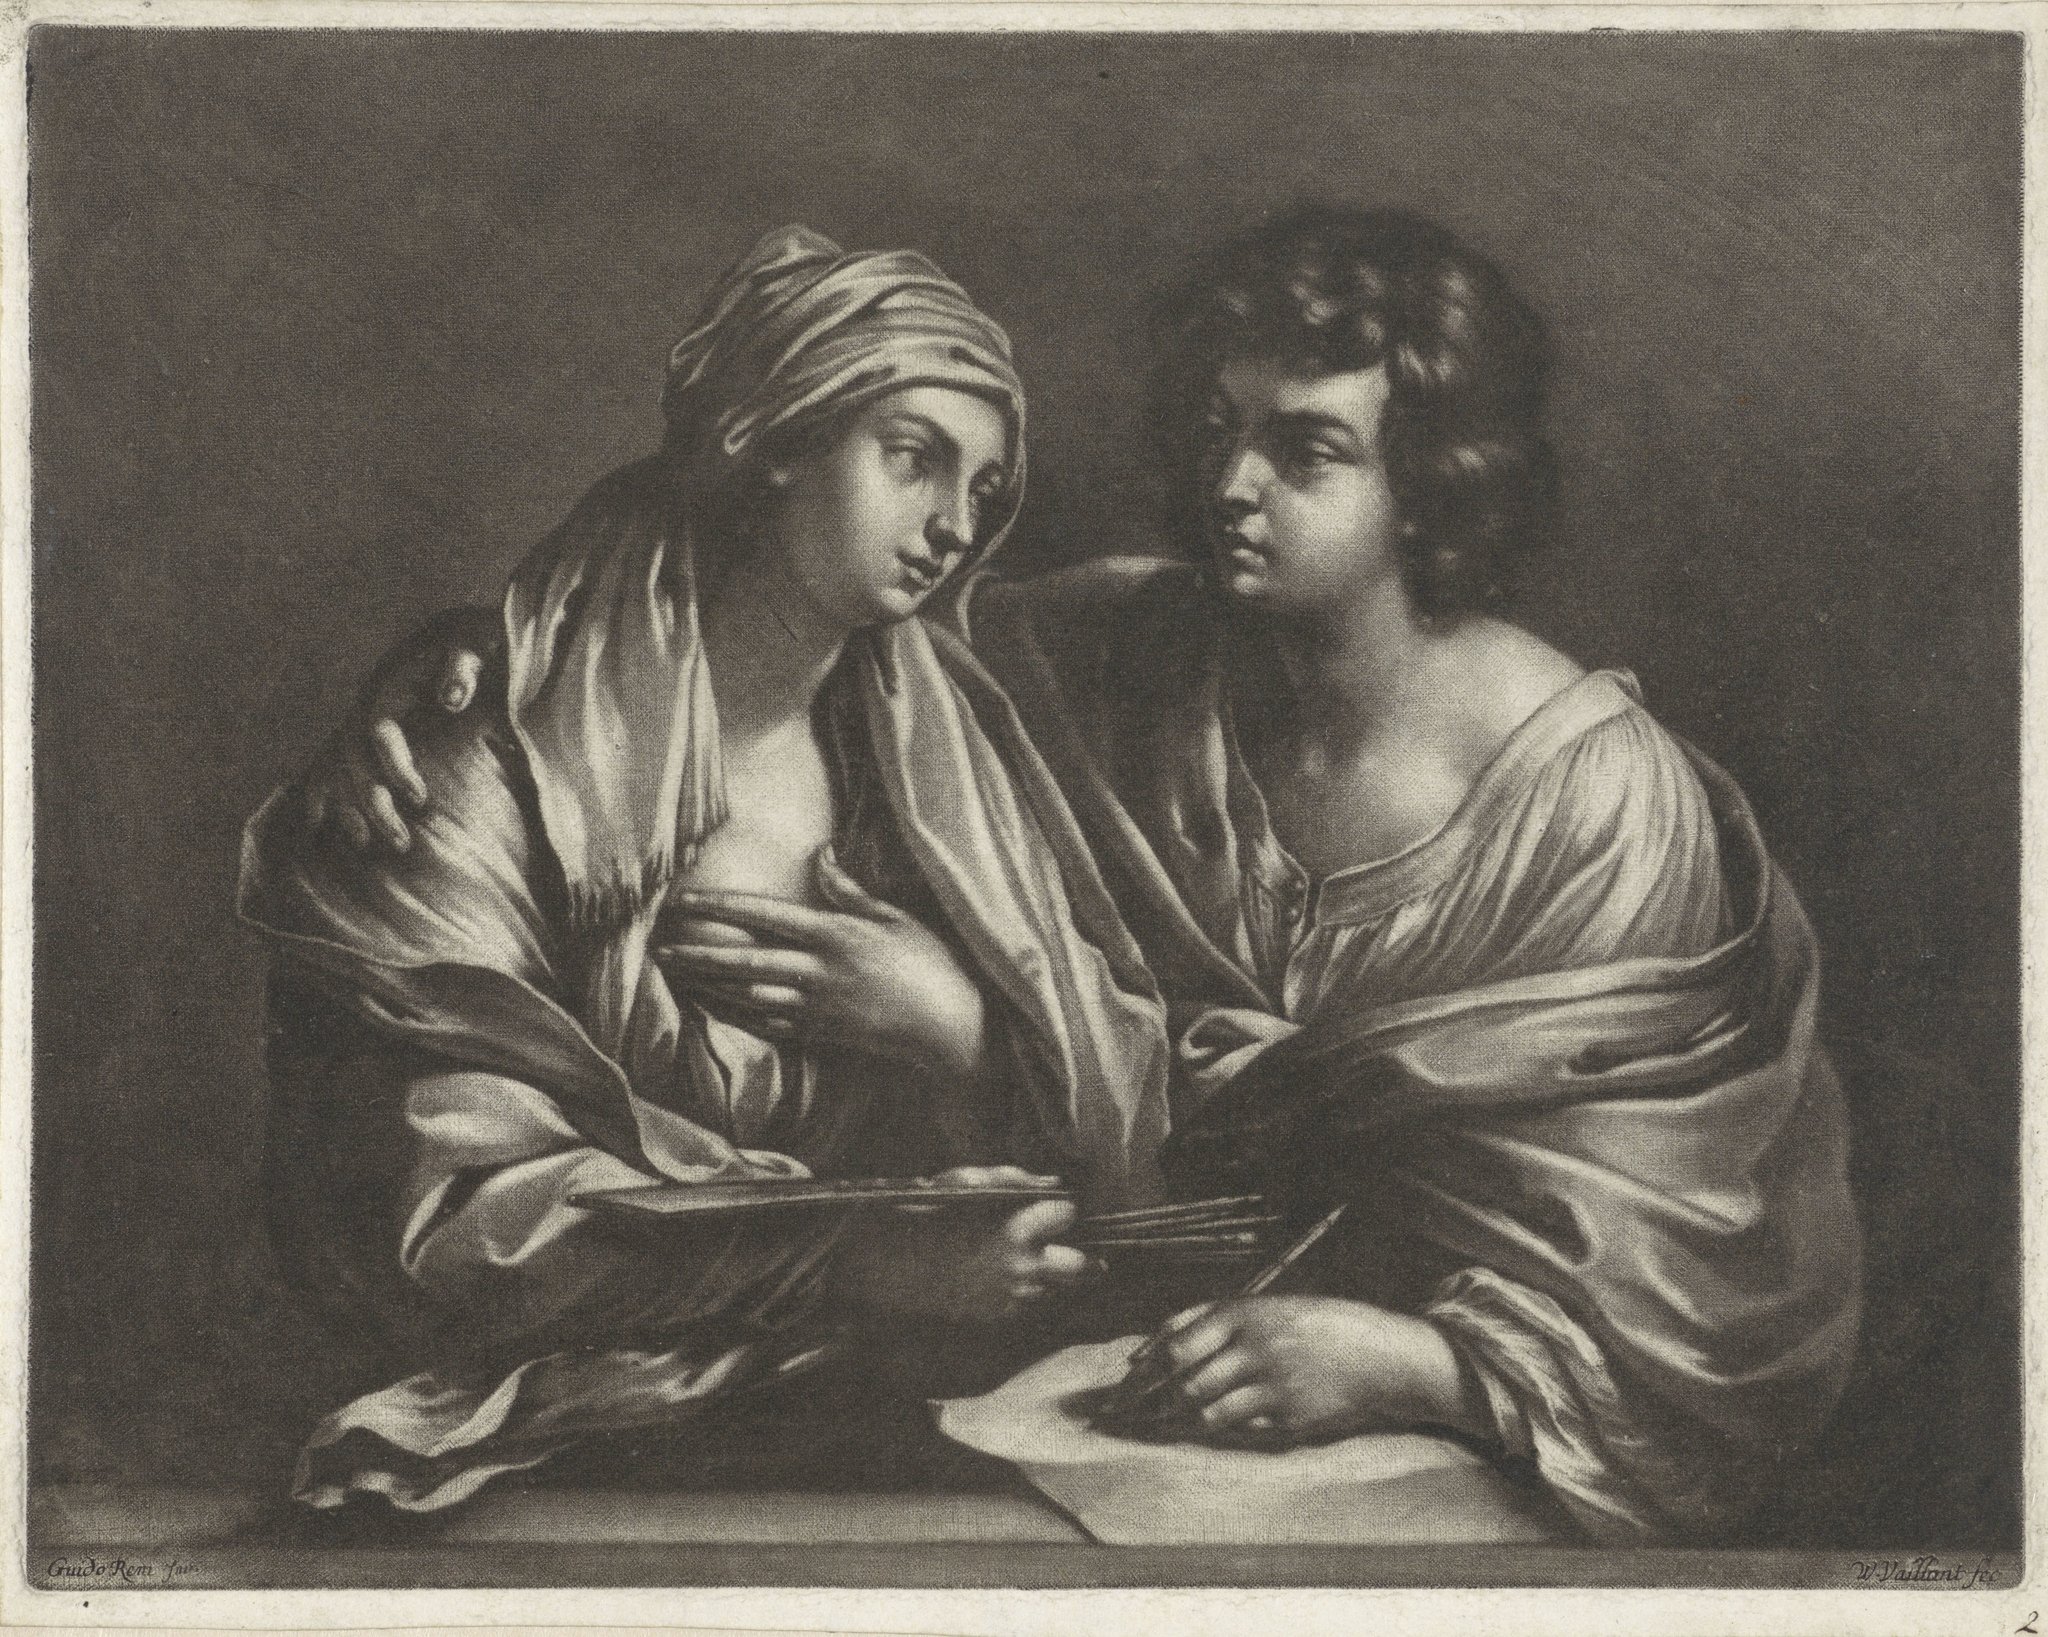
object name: print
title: Schilderkunst en tekenkunst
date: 1658-1677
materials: paper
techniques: mezzotint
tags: 'pictura', symbolic representations, allegories and emblems ~ painting; 'pittura' (ripa), tools, implements of draughtsman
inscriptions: collector's mark: Lugt 11, collector's mark: Lugt 10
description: De schilderkunst en de tekenkunst gepersonifieerd door een vrouw met schilderspalet en penselen en een jongeman met tekenstift en papier.